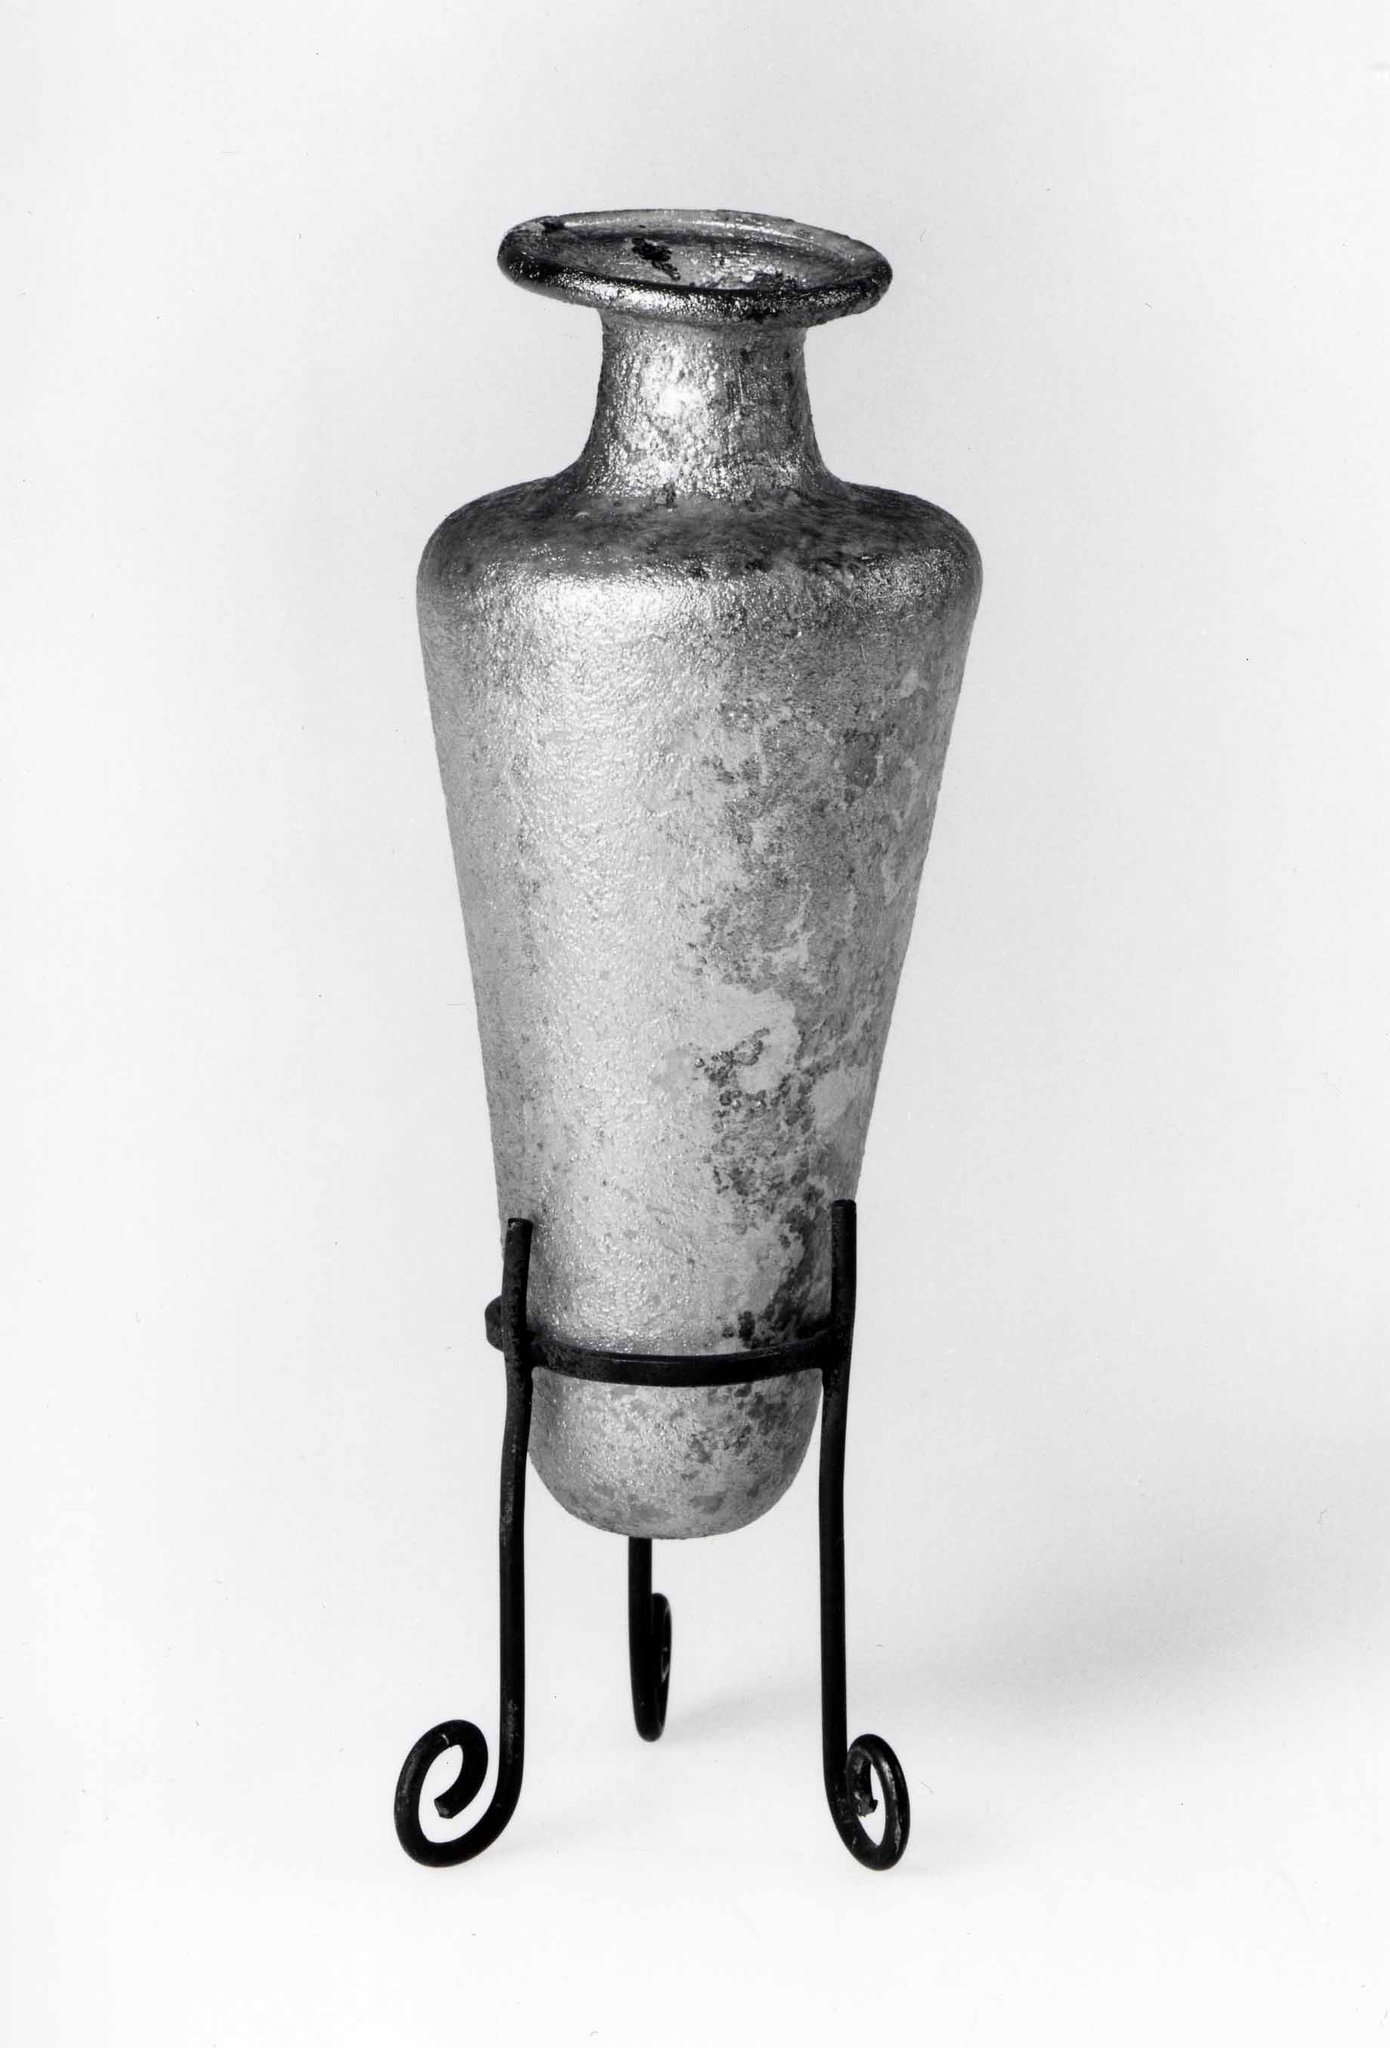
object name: jar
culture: roman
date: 201-300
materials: glass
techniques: glassblowing